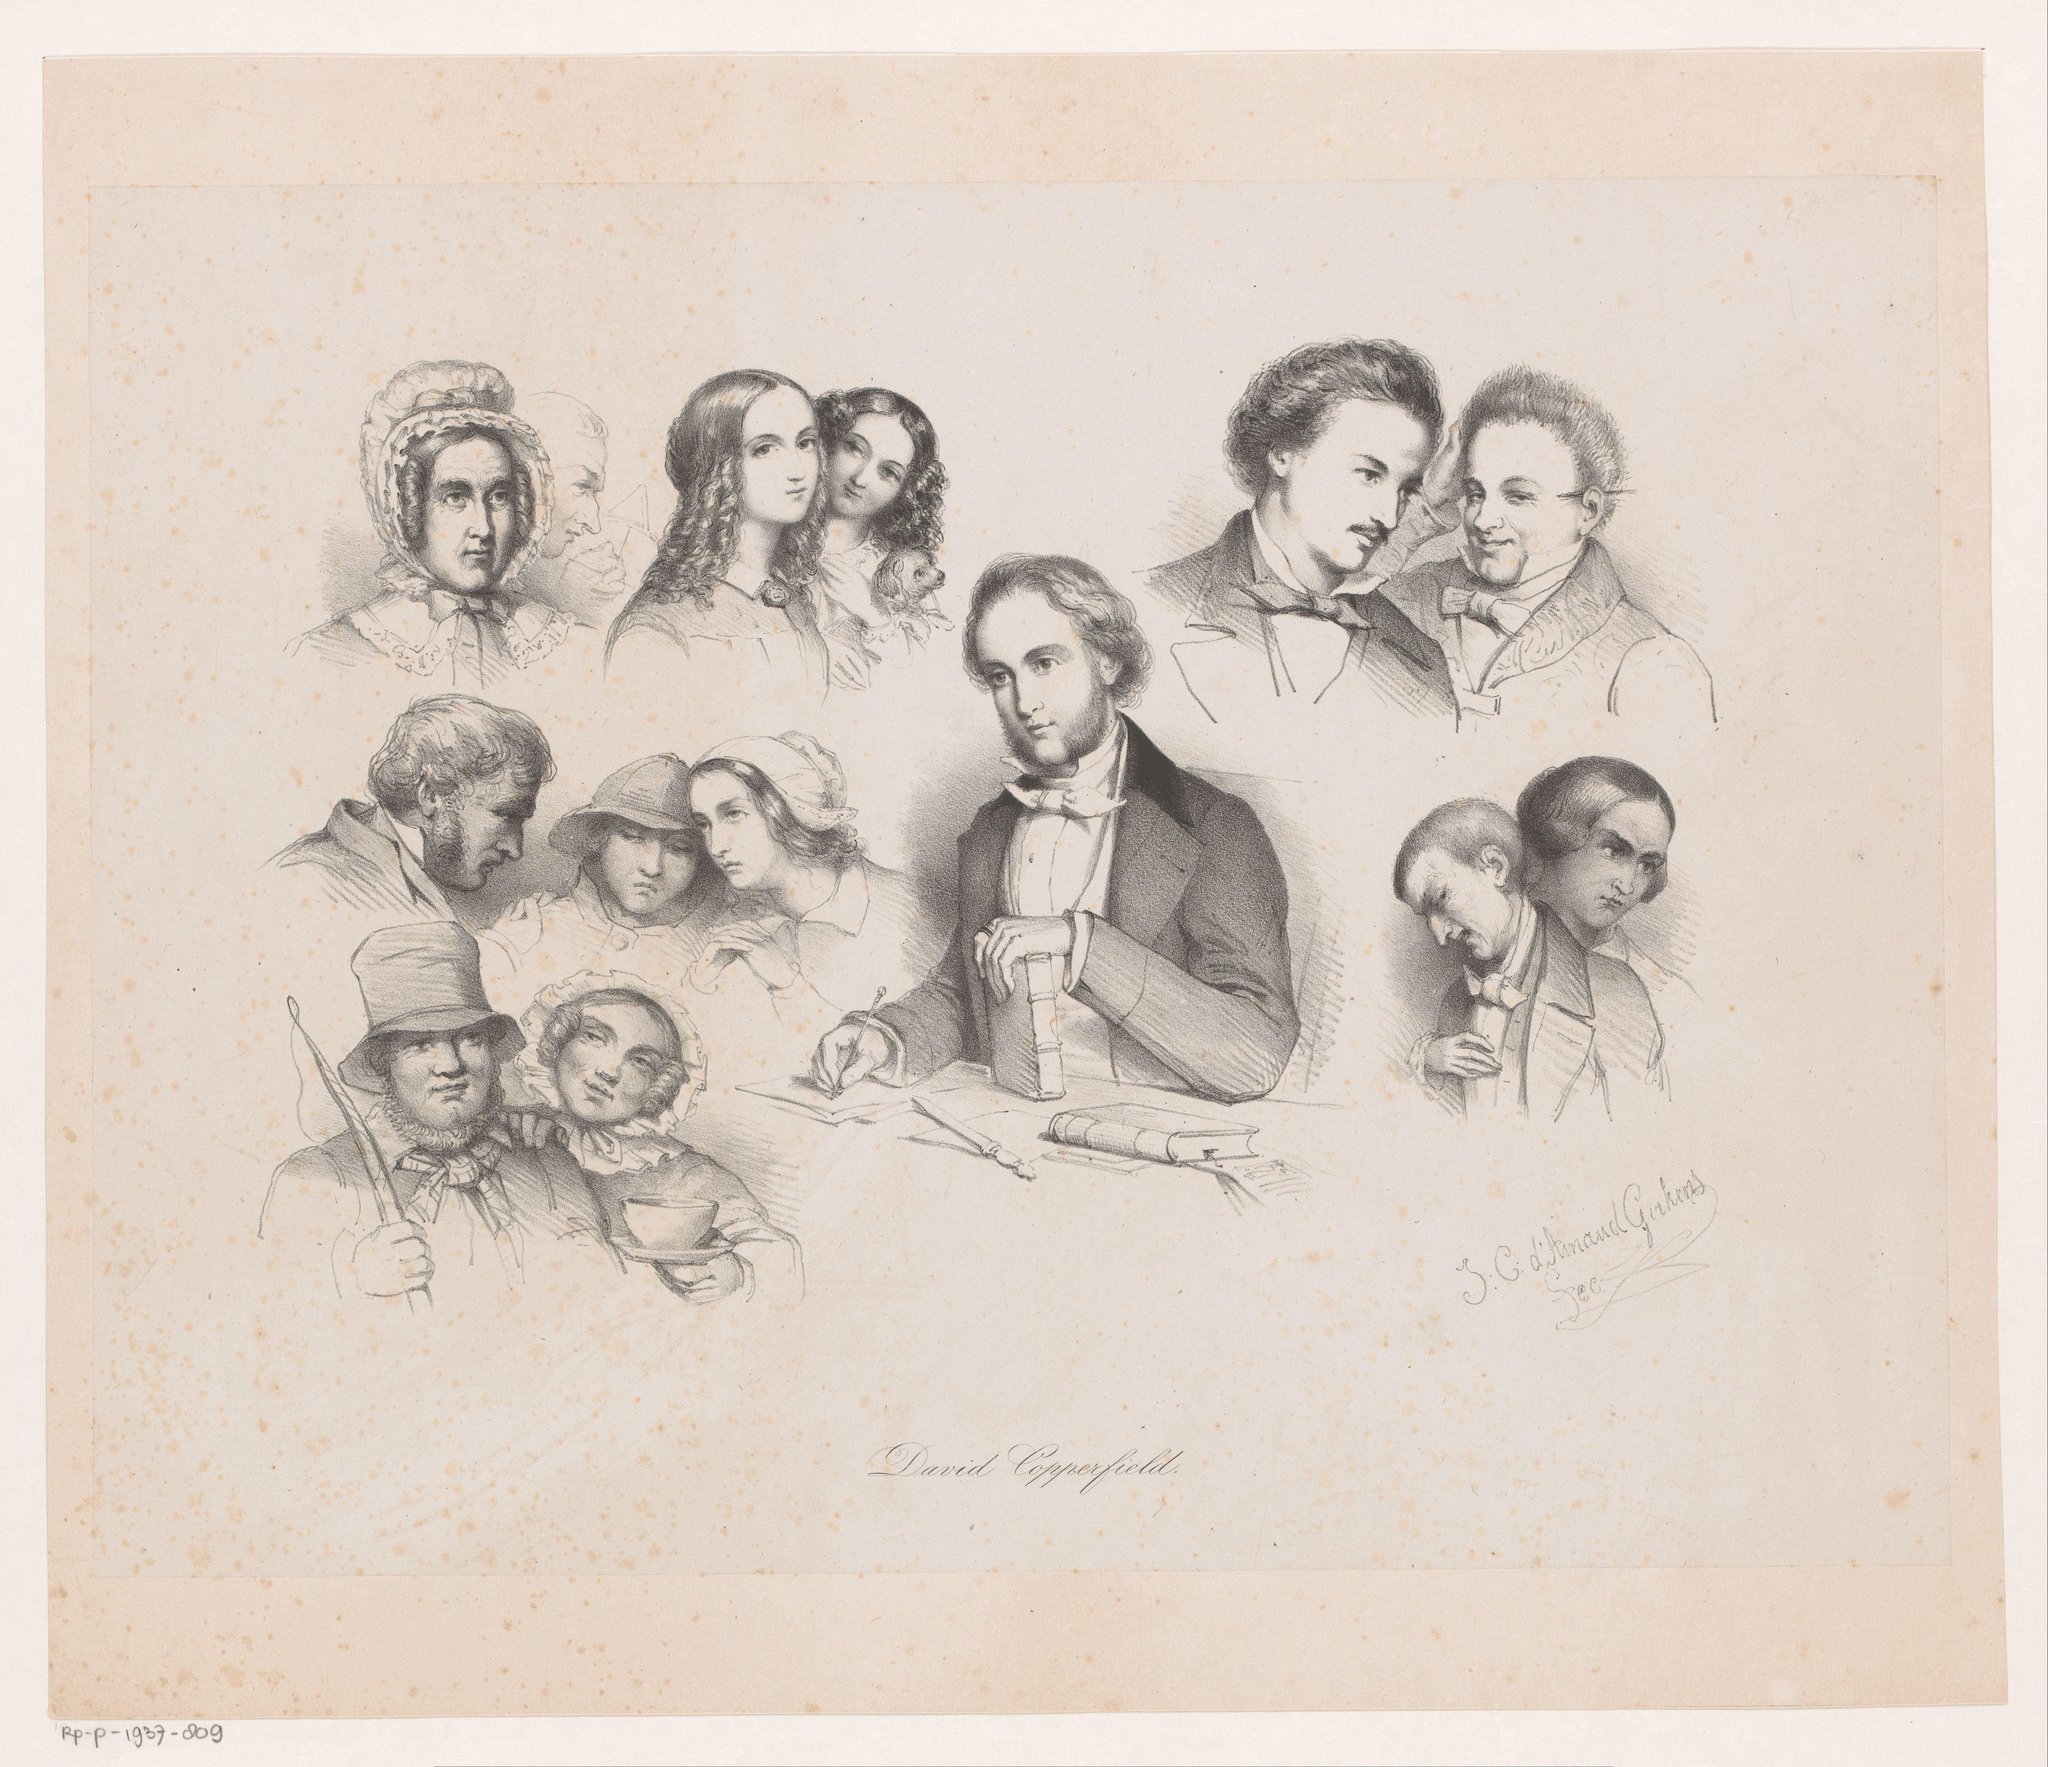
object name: print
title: David Copperfield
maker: johannes christiaan d arnaud gerkens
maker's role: draughtsman, print maker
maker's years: 1823-1892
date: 1852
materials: paper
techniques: lithograph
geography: netherlands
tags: portsmouth, literary characters and objects, historical persons (+ half-length portrait), author, poet writing, specific works of literature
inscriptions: collector's mark: Lugt 2760, collector's mark: Lugt 2228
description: Deze staat verschilt van de andere twee staten door de titel 'David Copperfield' en de signatuur zonder jaartal. Ook de afbeelding wijkt af van de andere staten. Zo is de blik van de vrouw uiterst rechts aangepast en heeft de vrouw linksonder een ander kopje vast. Volgens een notitie op het verso werd deze prent gemaakt naar een tekening door Jacob Groenevelt (1840-1901).